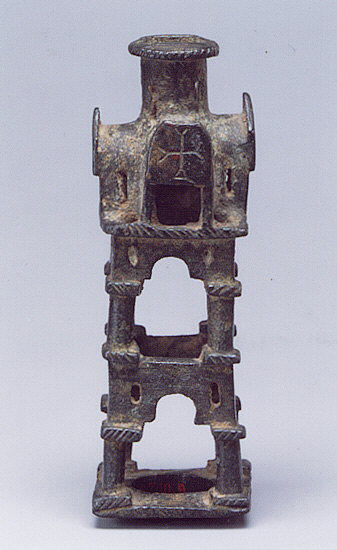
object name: cross base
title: Base for a Cross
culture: byzantine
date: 1001-1100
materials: copper alloy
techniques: casting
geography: probably constantinople or asia minor